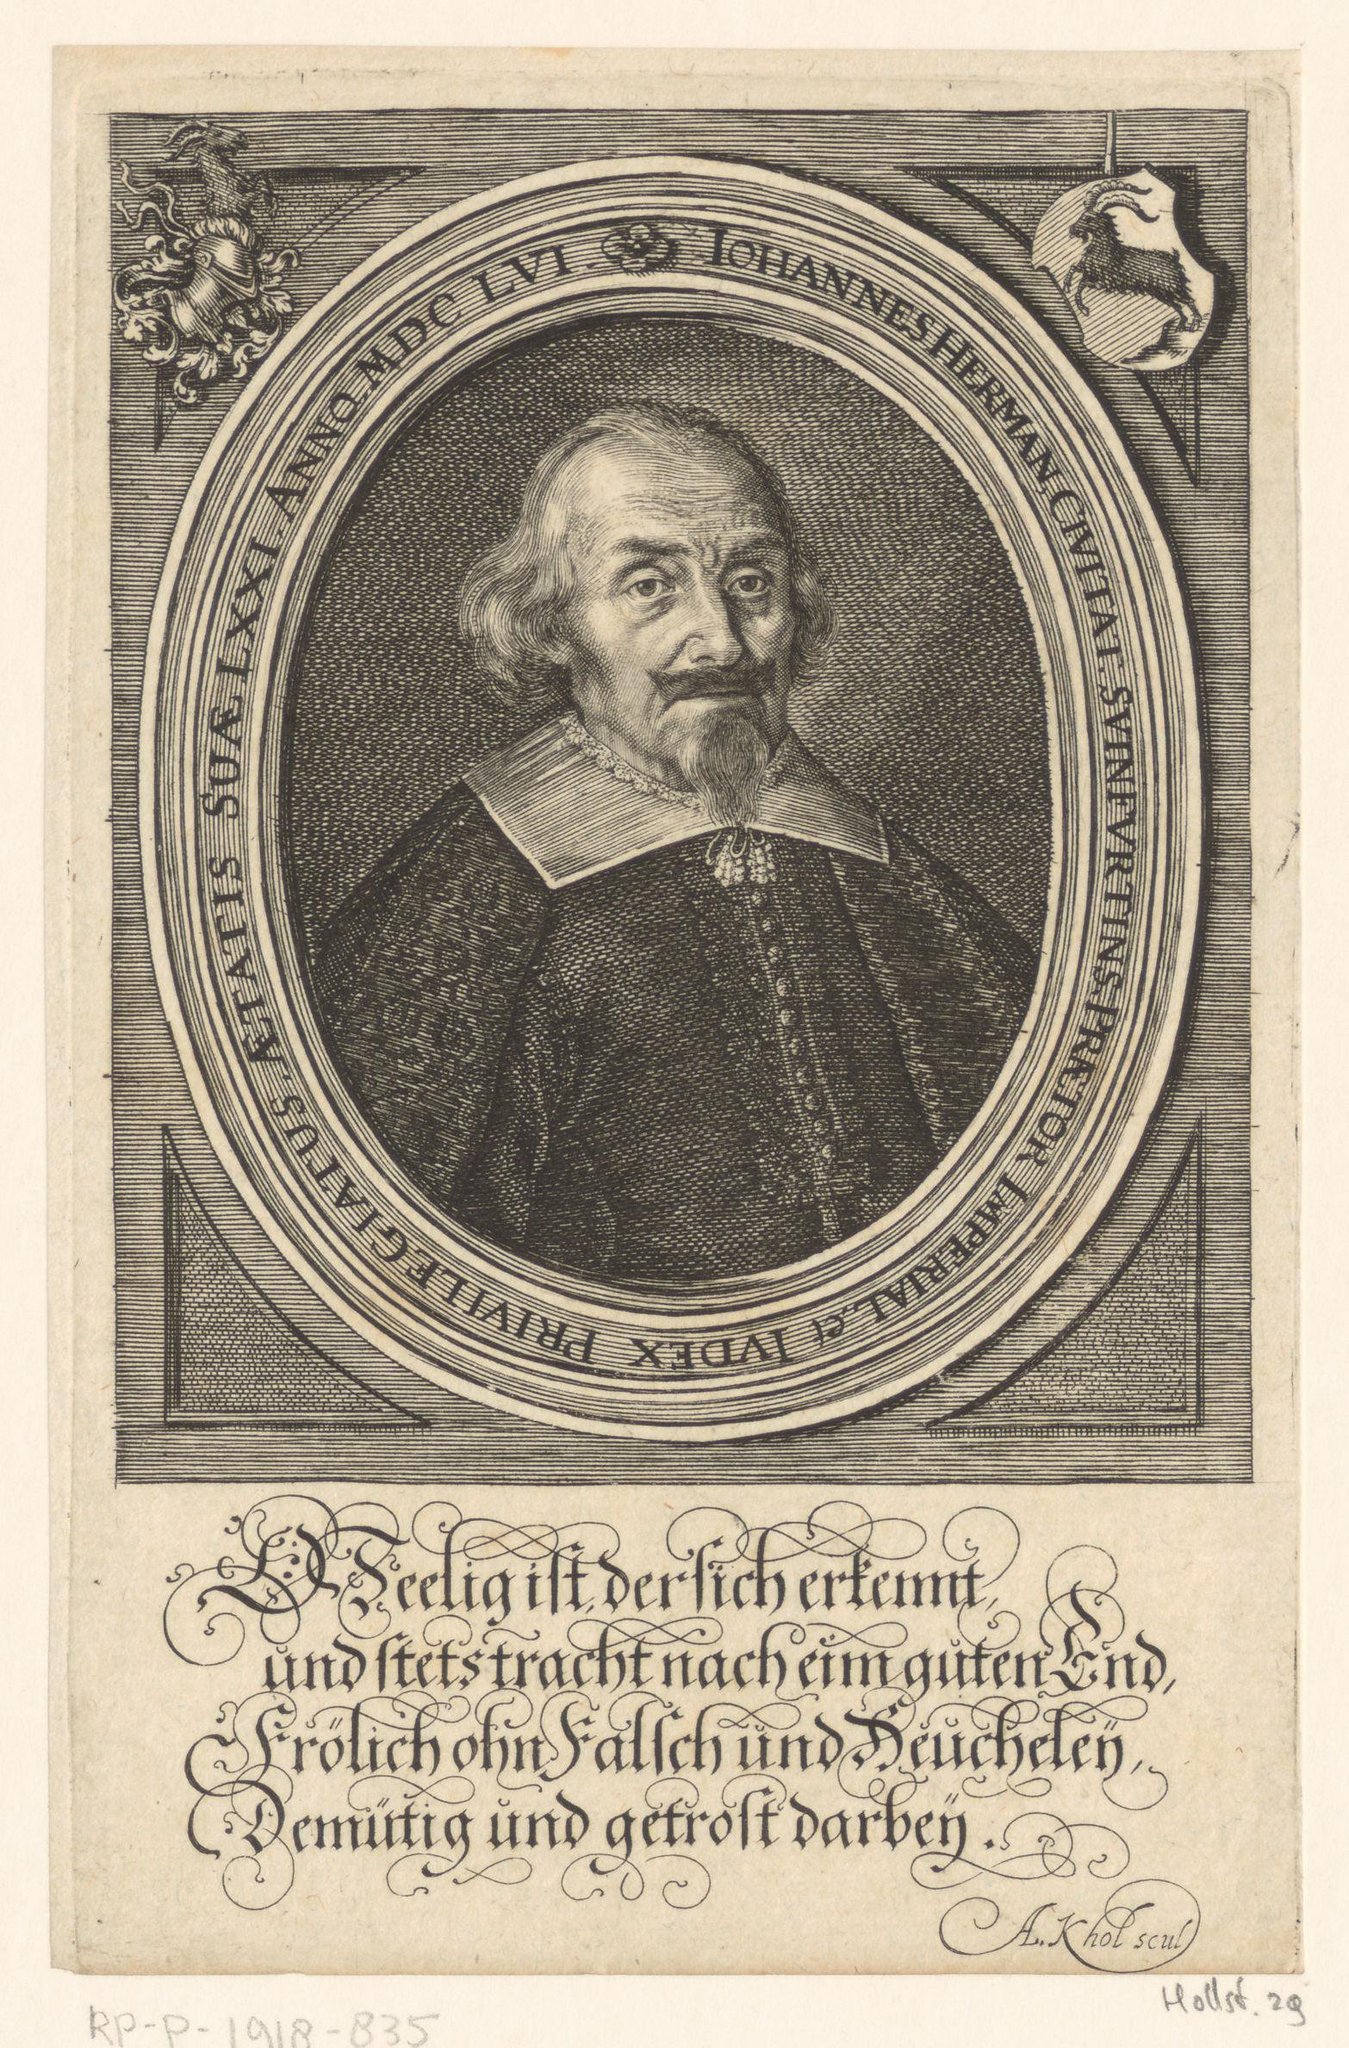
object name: print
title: Portret van Johann Herman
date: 1656-1657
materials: paper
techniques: engraving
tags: historical persons, lawyer, attorney at law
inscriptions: collector's mark: Lugt 2233